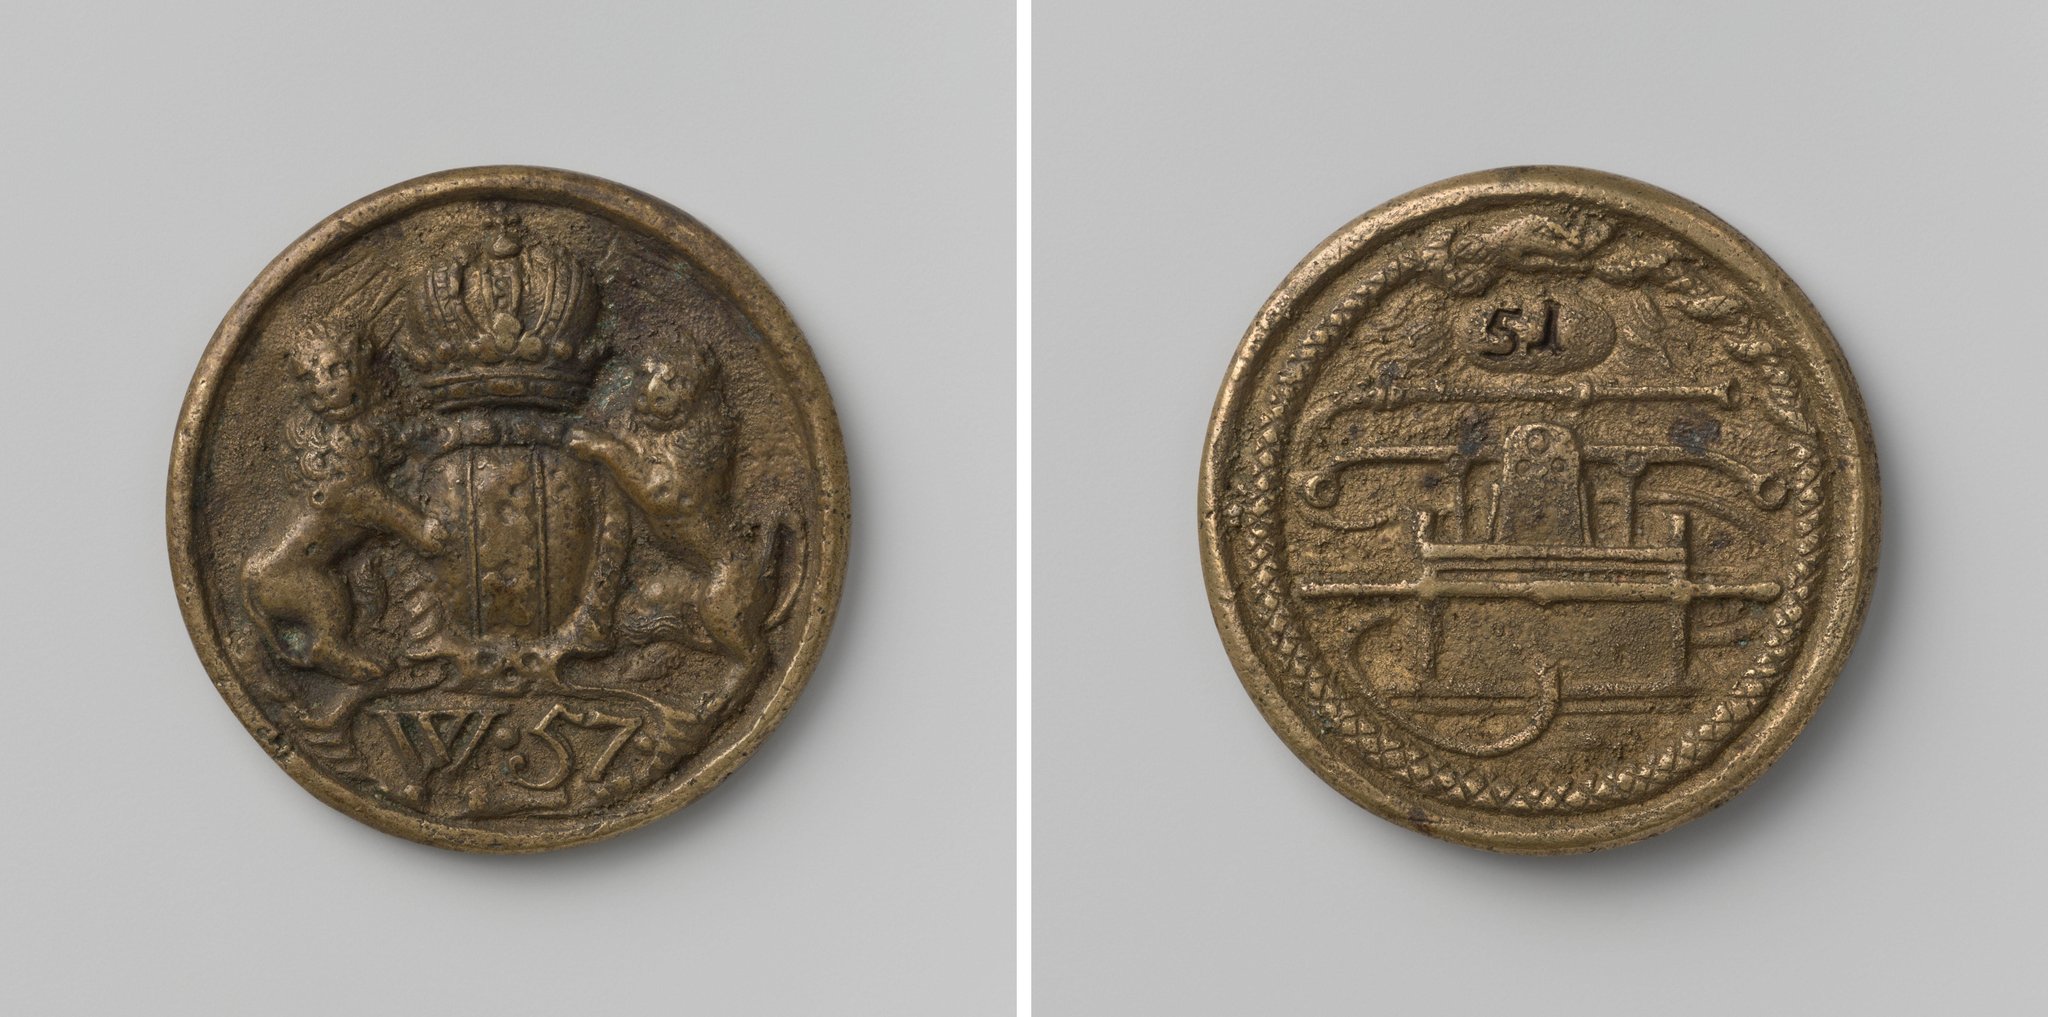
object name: medal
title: Amsterdam, brandspuitpenning van wijk 57 met no. 51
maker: Anonymous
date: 1680-1800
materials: brass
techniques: casting, engraving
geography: amsterdam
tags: amsterdam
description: Messing penning. Voorzijde: gekroond wapenschild, geflankeerd door twee leeuwen boven cartouche met opschrift W 57. Keerzijde: brandspuit onder cartouche met no. 51 binnen slangerond